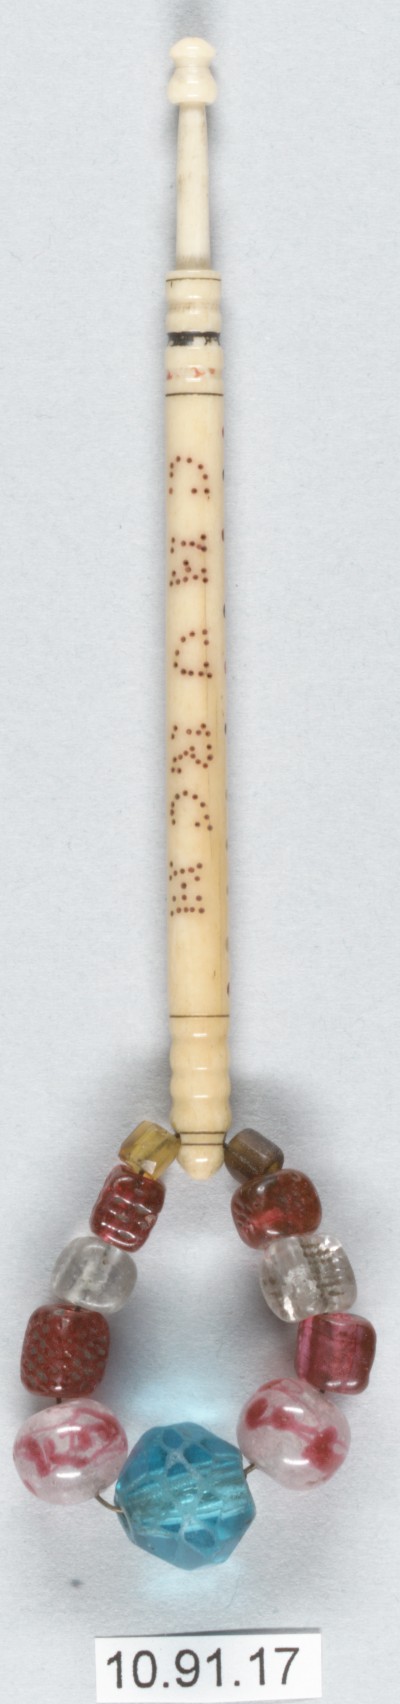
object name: bobbin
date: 1801-1900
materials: bone